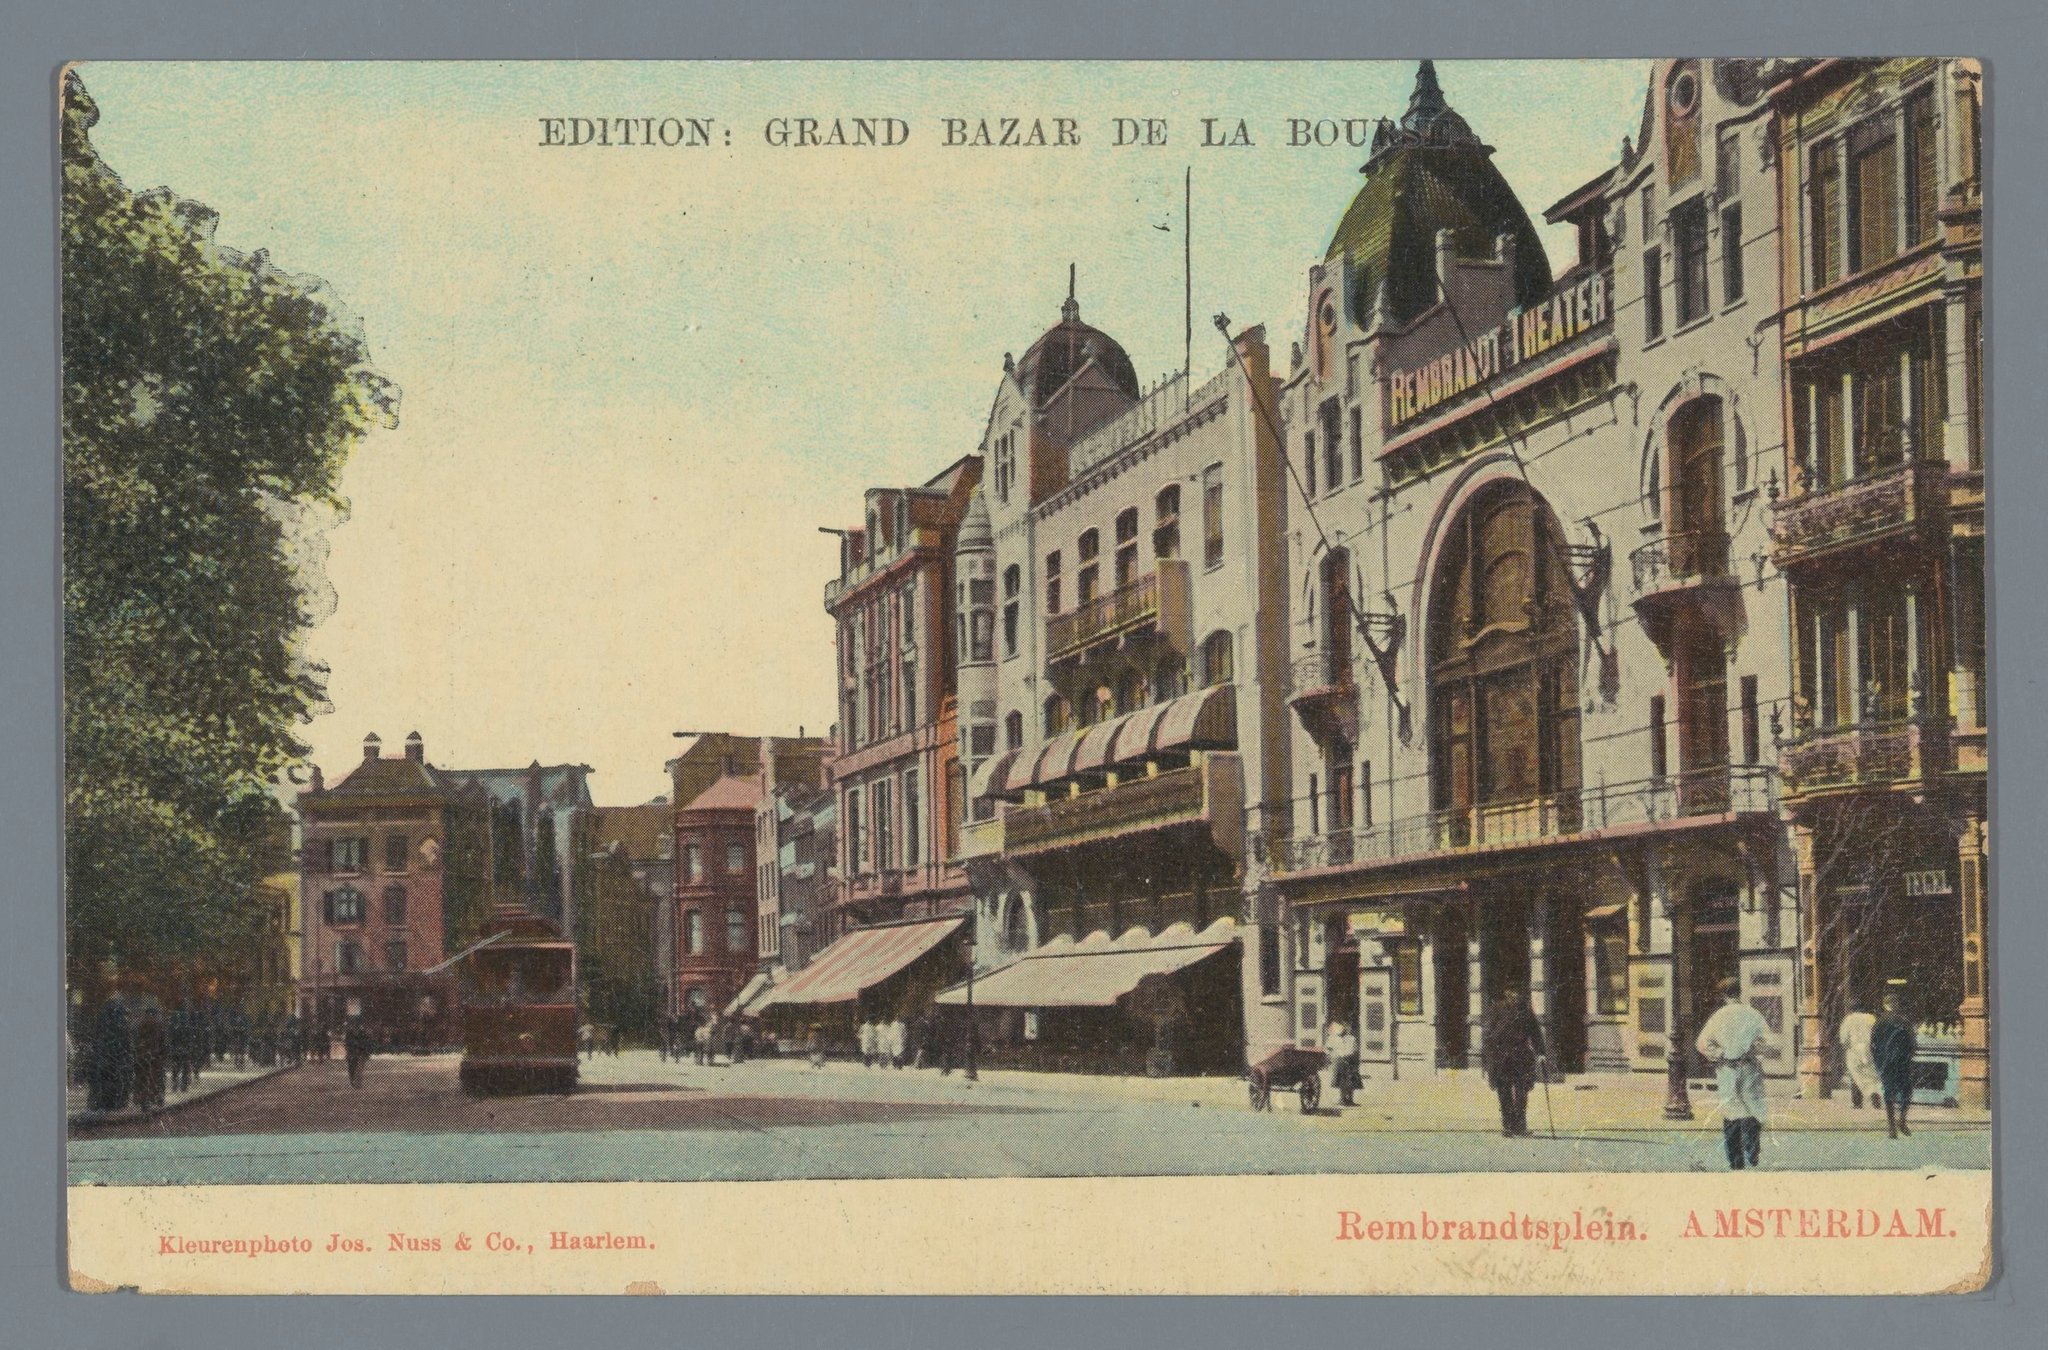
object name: photomechanical print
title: Rembrandtsplein, Amsterdam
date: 1906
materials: cardboard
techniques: writing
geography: haarlem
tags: square, place, circus, etc.